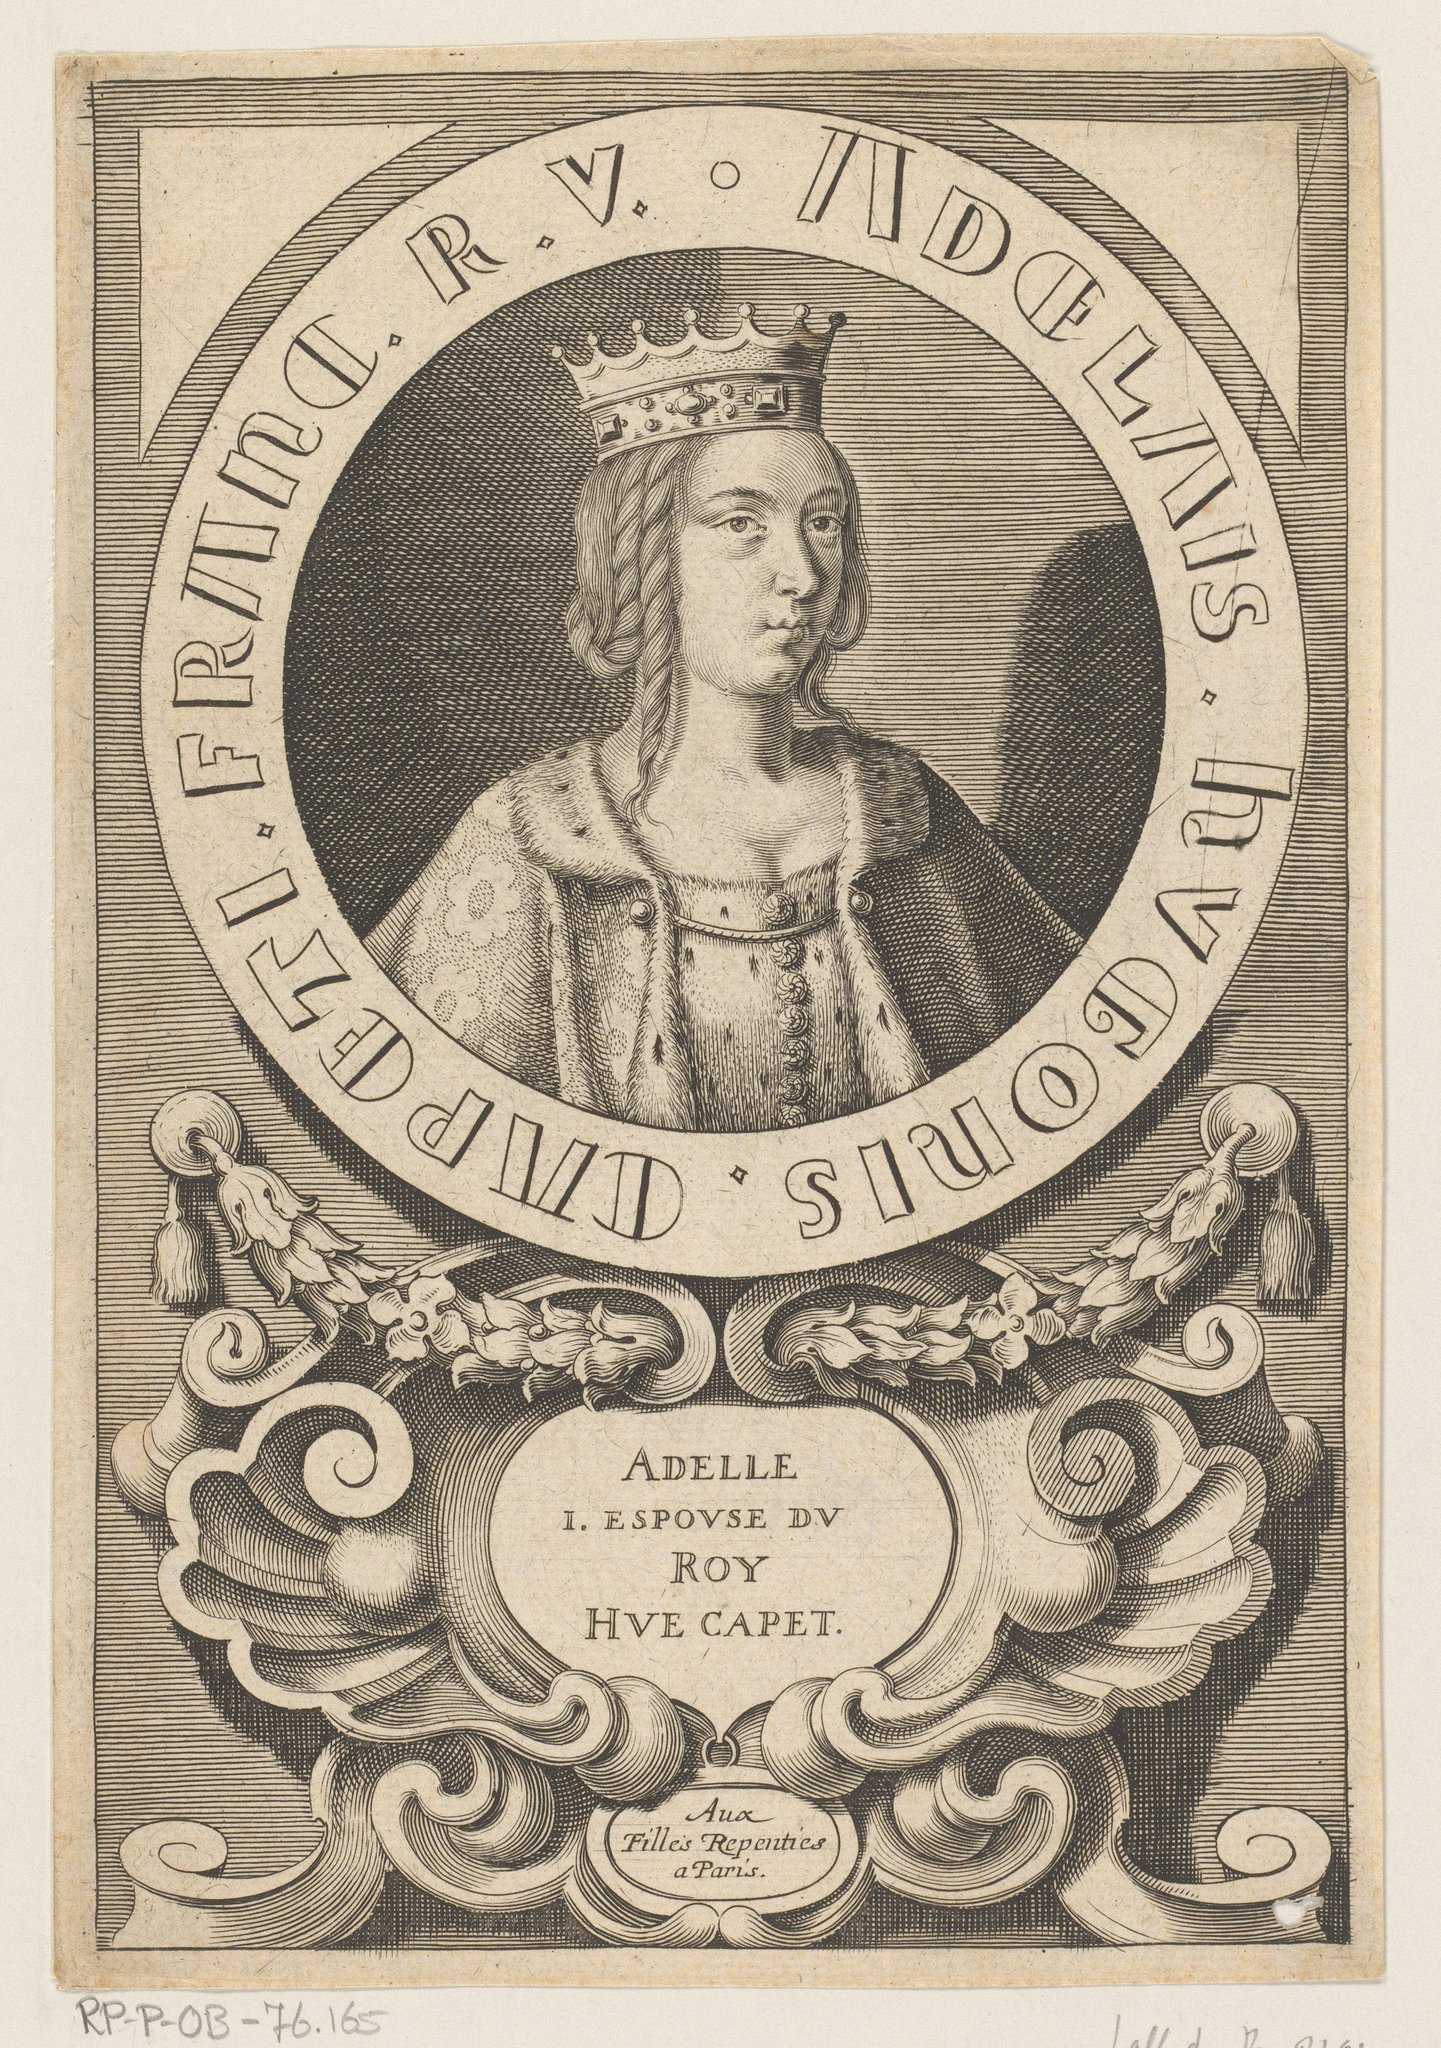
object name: book illustration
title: Portret van Adelheid van Poitiers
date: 1634-1685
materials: paper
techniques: engraving, letterpress printing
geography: paris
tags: historical persons, queen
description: Prent waarschijnlijk voor het eerst verschenen in: Bie, Jacques de. Les vrais portraits des rois de France (...). Parijs: Jacques de Bie en Pierre Rocolet, 1634. Prent ook gebruikt in latere publicaties, in ieder geval tot in 1685.